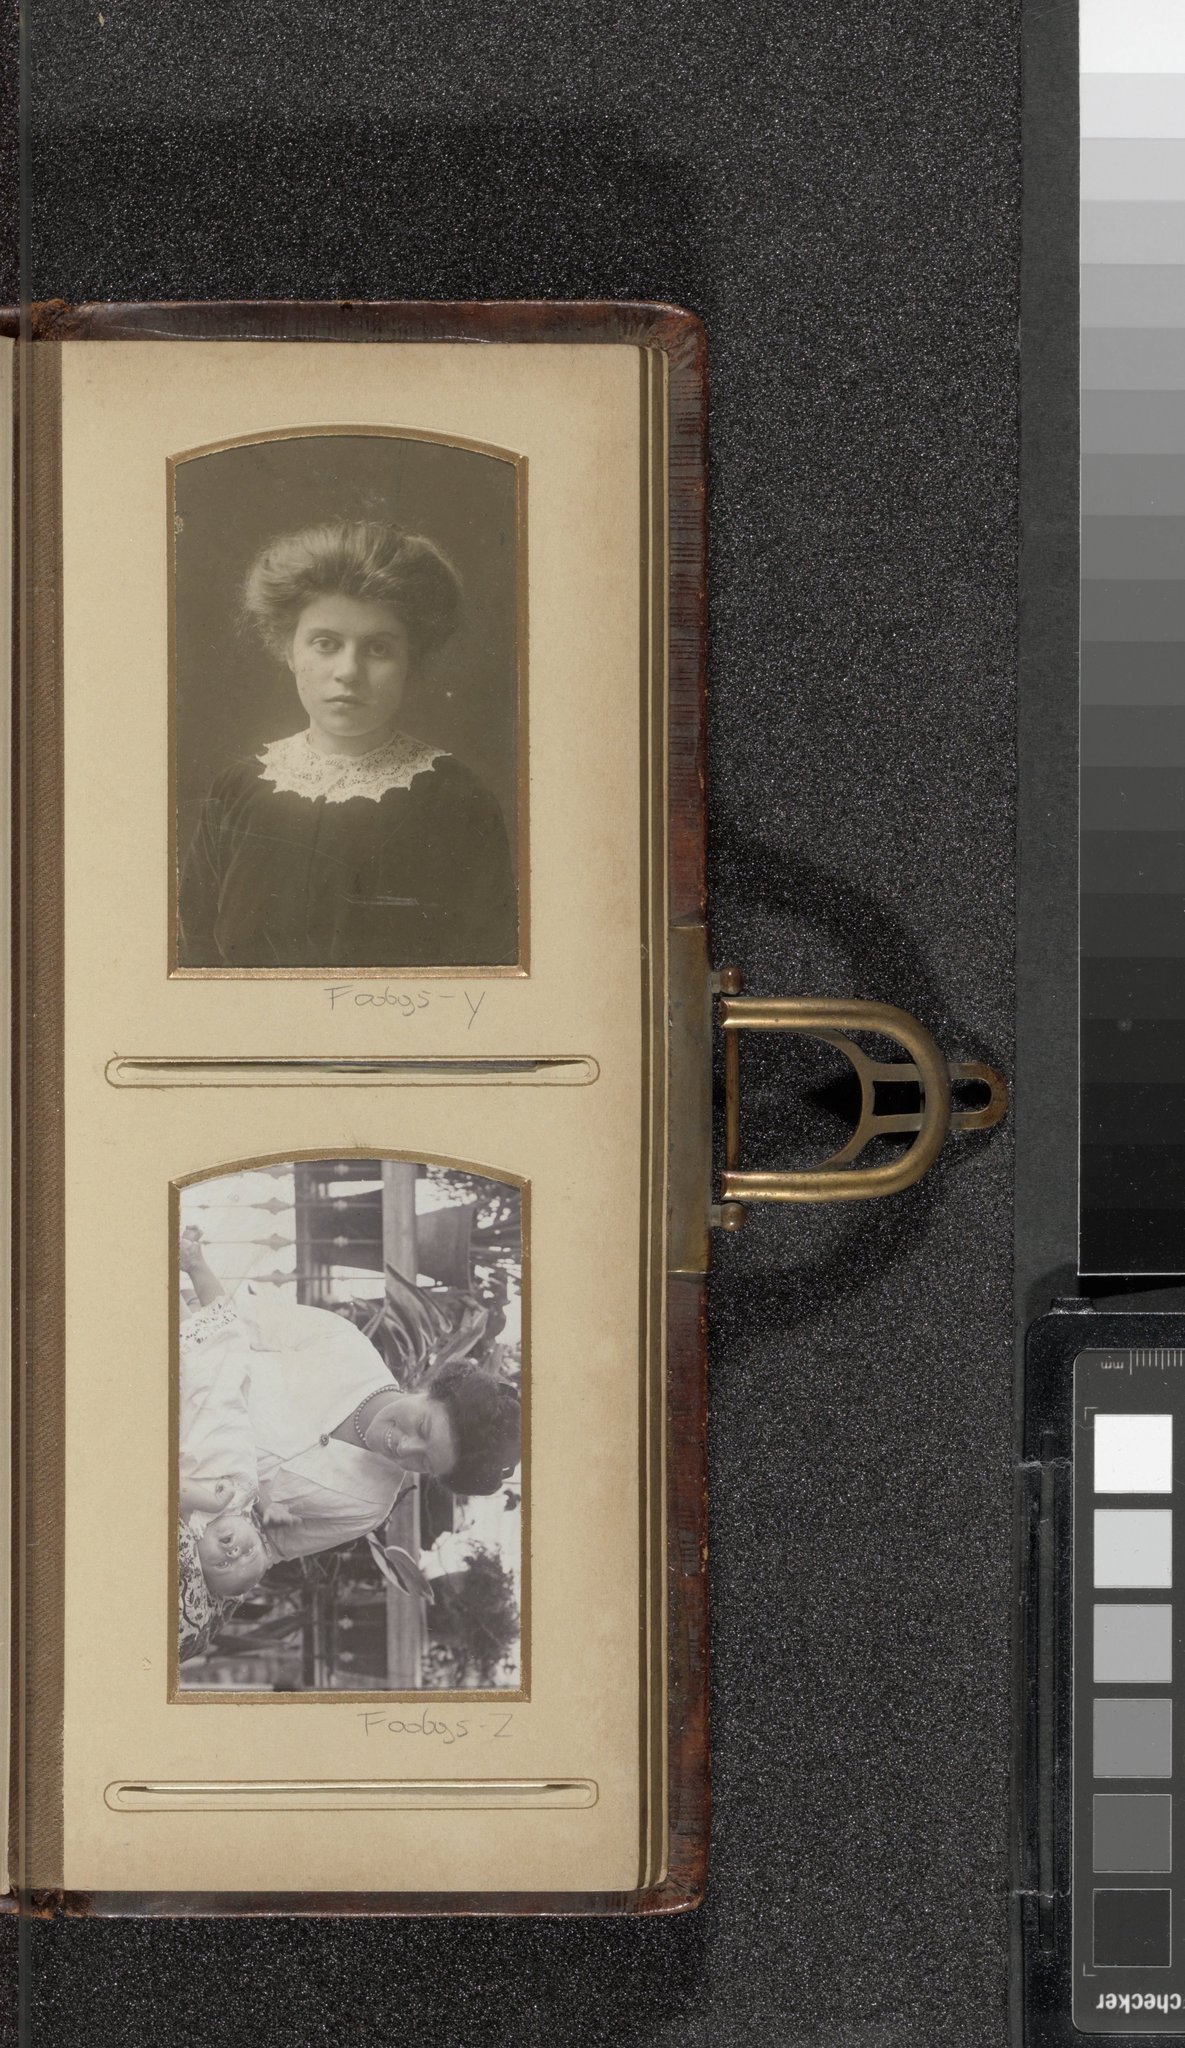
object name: photograph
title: Portret van een jonge vrouw met opgestoken haar en kanten kraag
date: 1900-1920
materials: cardboard, paper, photographic support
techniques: gelatin silver print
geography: haarlem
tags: adolescent, young woman, maiden, styles of hairdress - aa - ~ women, haarlem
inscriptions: address: ‘Groote Houtstraat. 92 Haarlem’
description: Onderdeel van Album met 28 foto's van een Nederlands-Surinaamse familie.